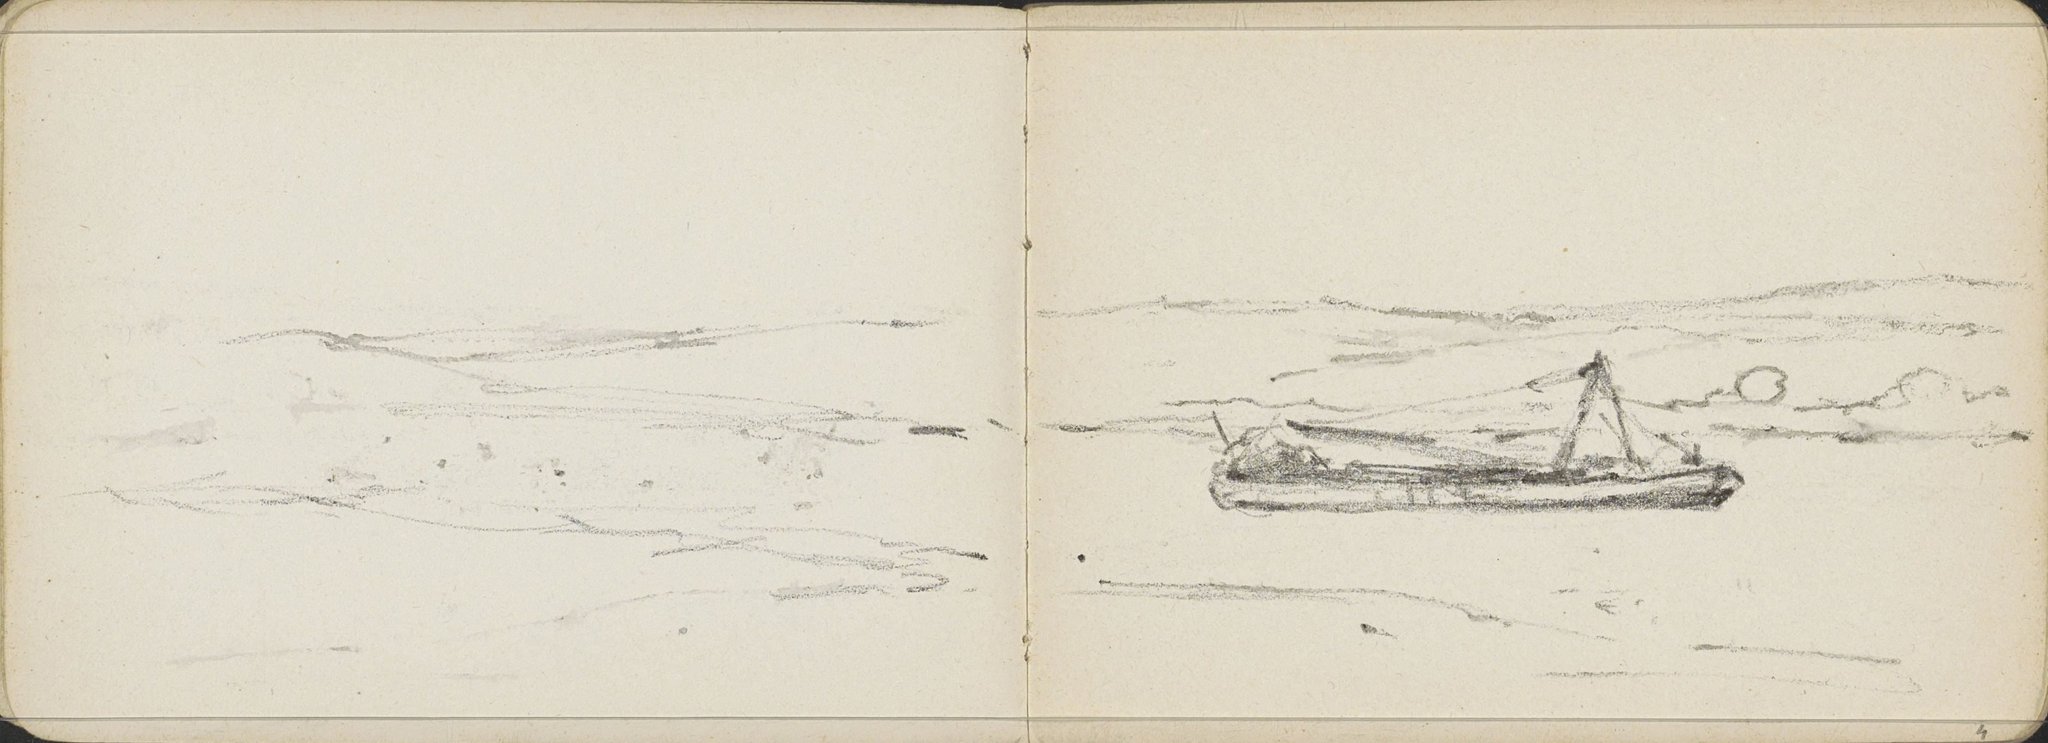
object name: sketchbook leaf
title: Boot op een rivier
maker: willem cornelis rip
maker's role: draughtsman, painter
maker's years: 1856-1922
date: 1905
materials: chalk, paper, watercolor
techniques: brush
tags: sailing-ship, sailing-boat, river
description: Blad 3 verso en 4 recto uit een schetsboek met 42 bladen.